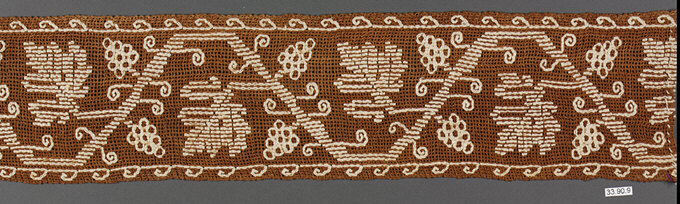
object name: border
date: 1501-1600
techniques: embroidery